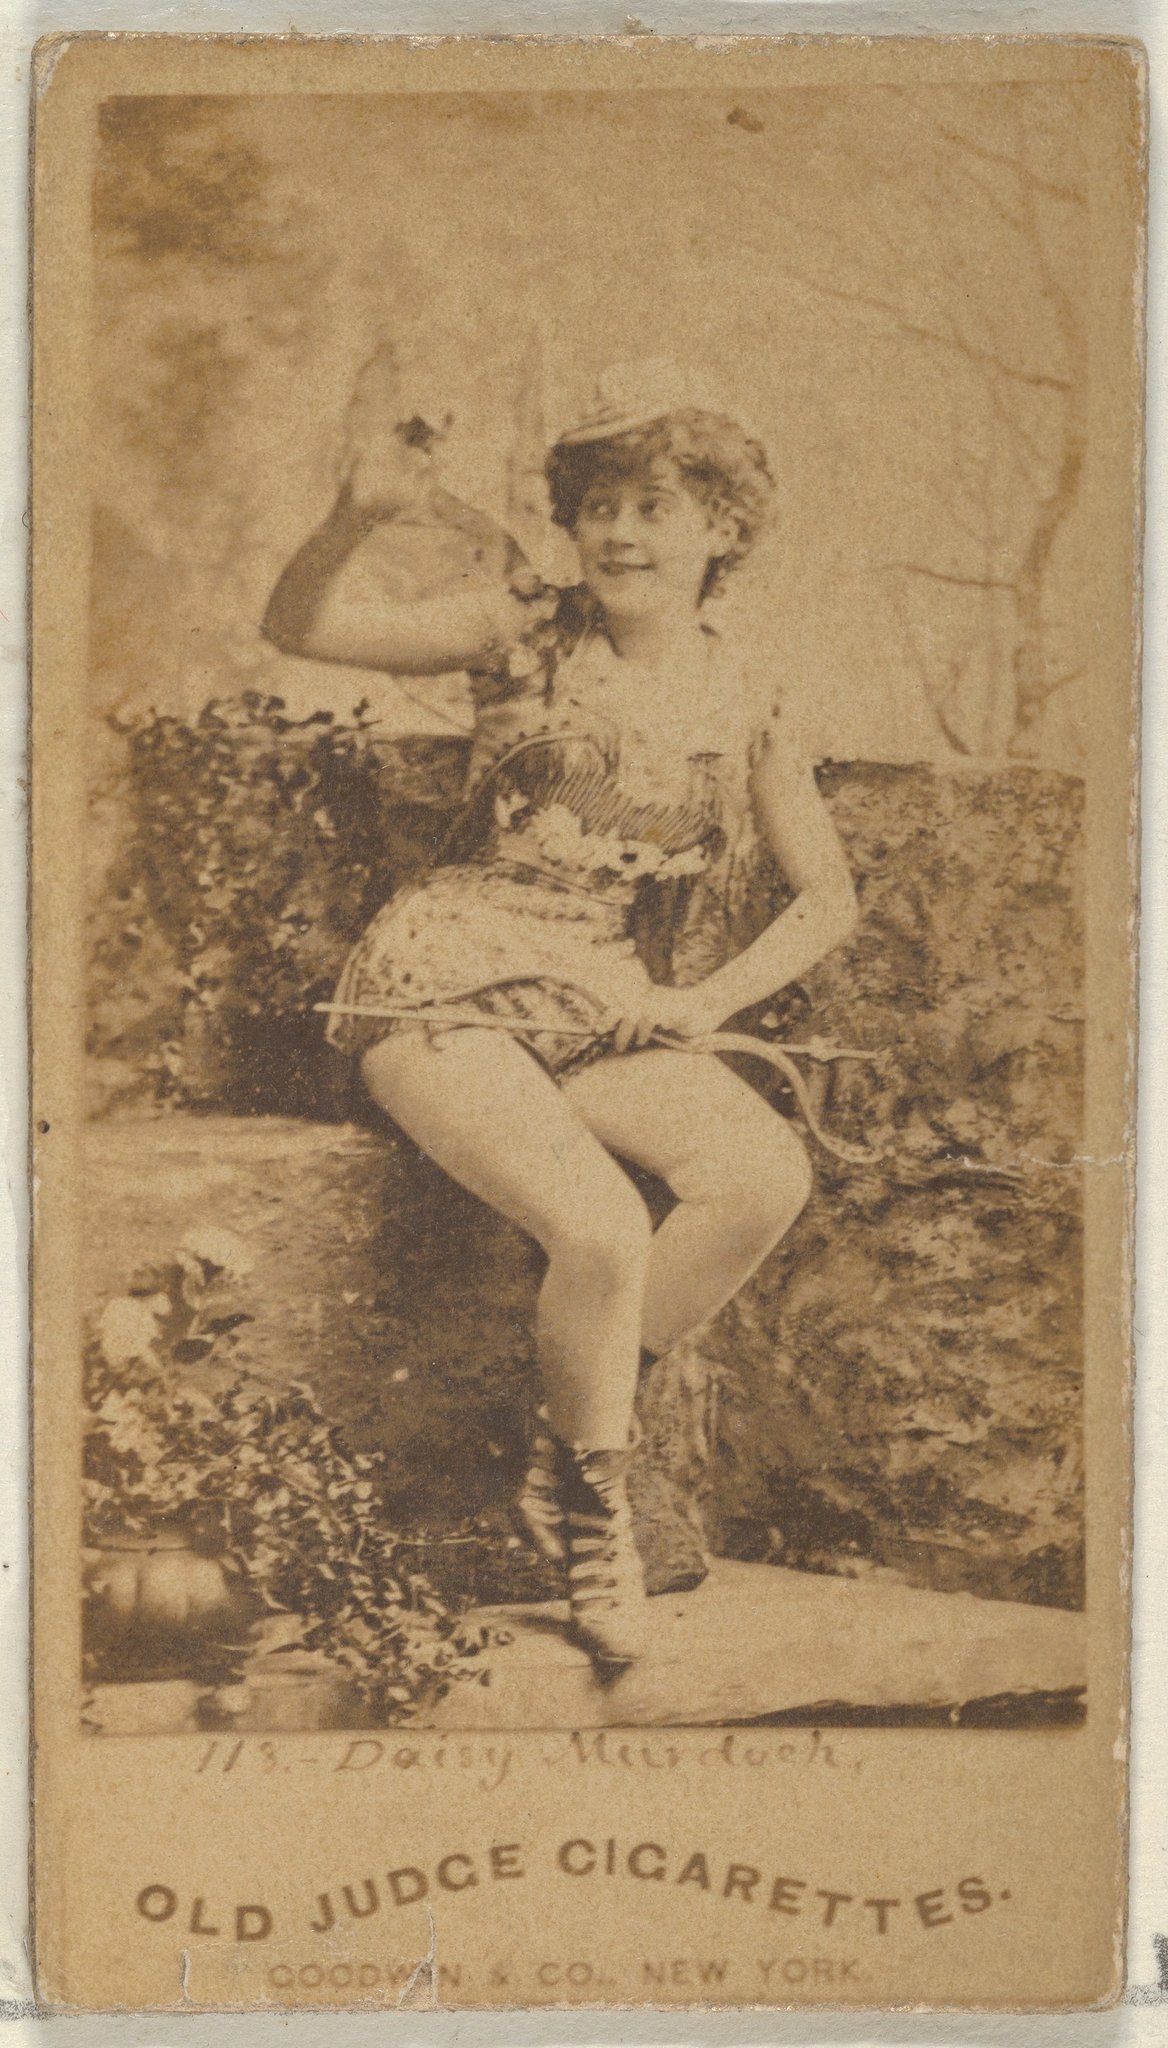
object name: photograph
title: Daisy Murdoch, from the Actors and Actresses series (N171) for Old Judge Cigarettes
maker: goodwin & company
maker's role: publisher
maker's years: 1850-1950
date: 1886-1890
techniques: albumen silver print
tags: portraits,women,actresses